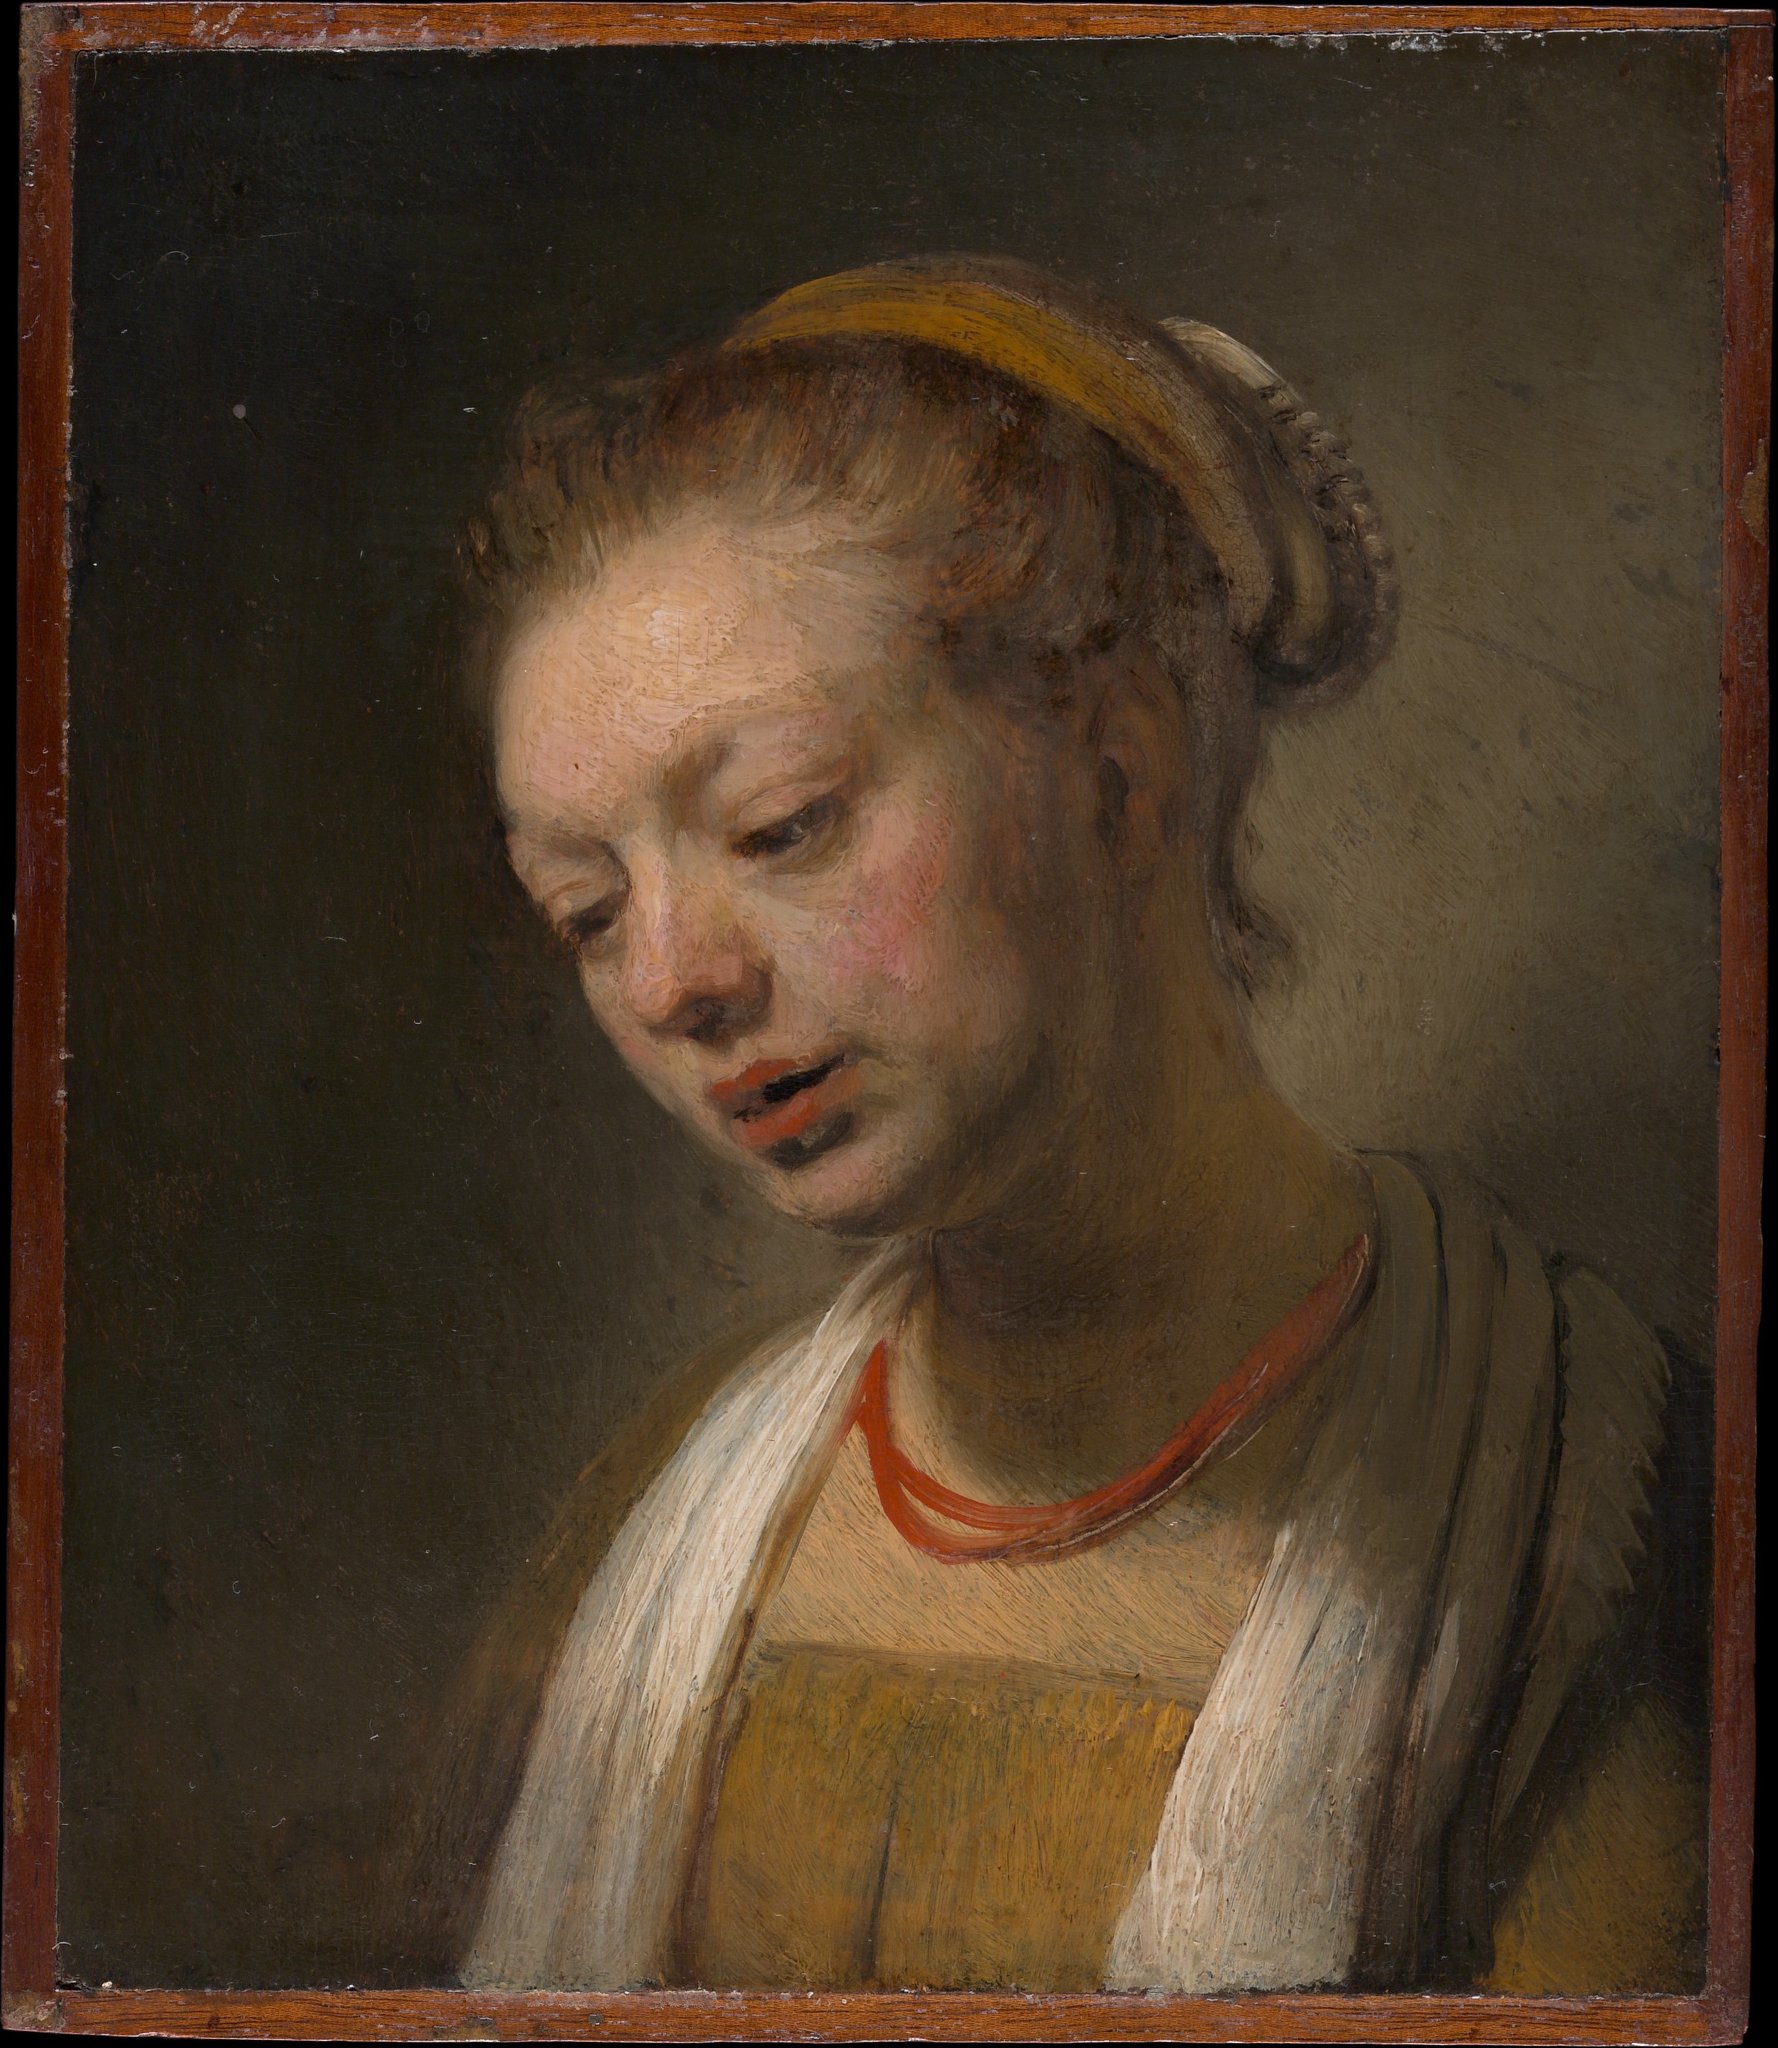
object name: painting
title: Young Woman with a Red Necklace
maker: rembrandt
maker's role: artist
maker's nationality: dutch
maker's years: 1606-1669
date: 1645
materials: oil, wood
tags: portraits,women